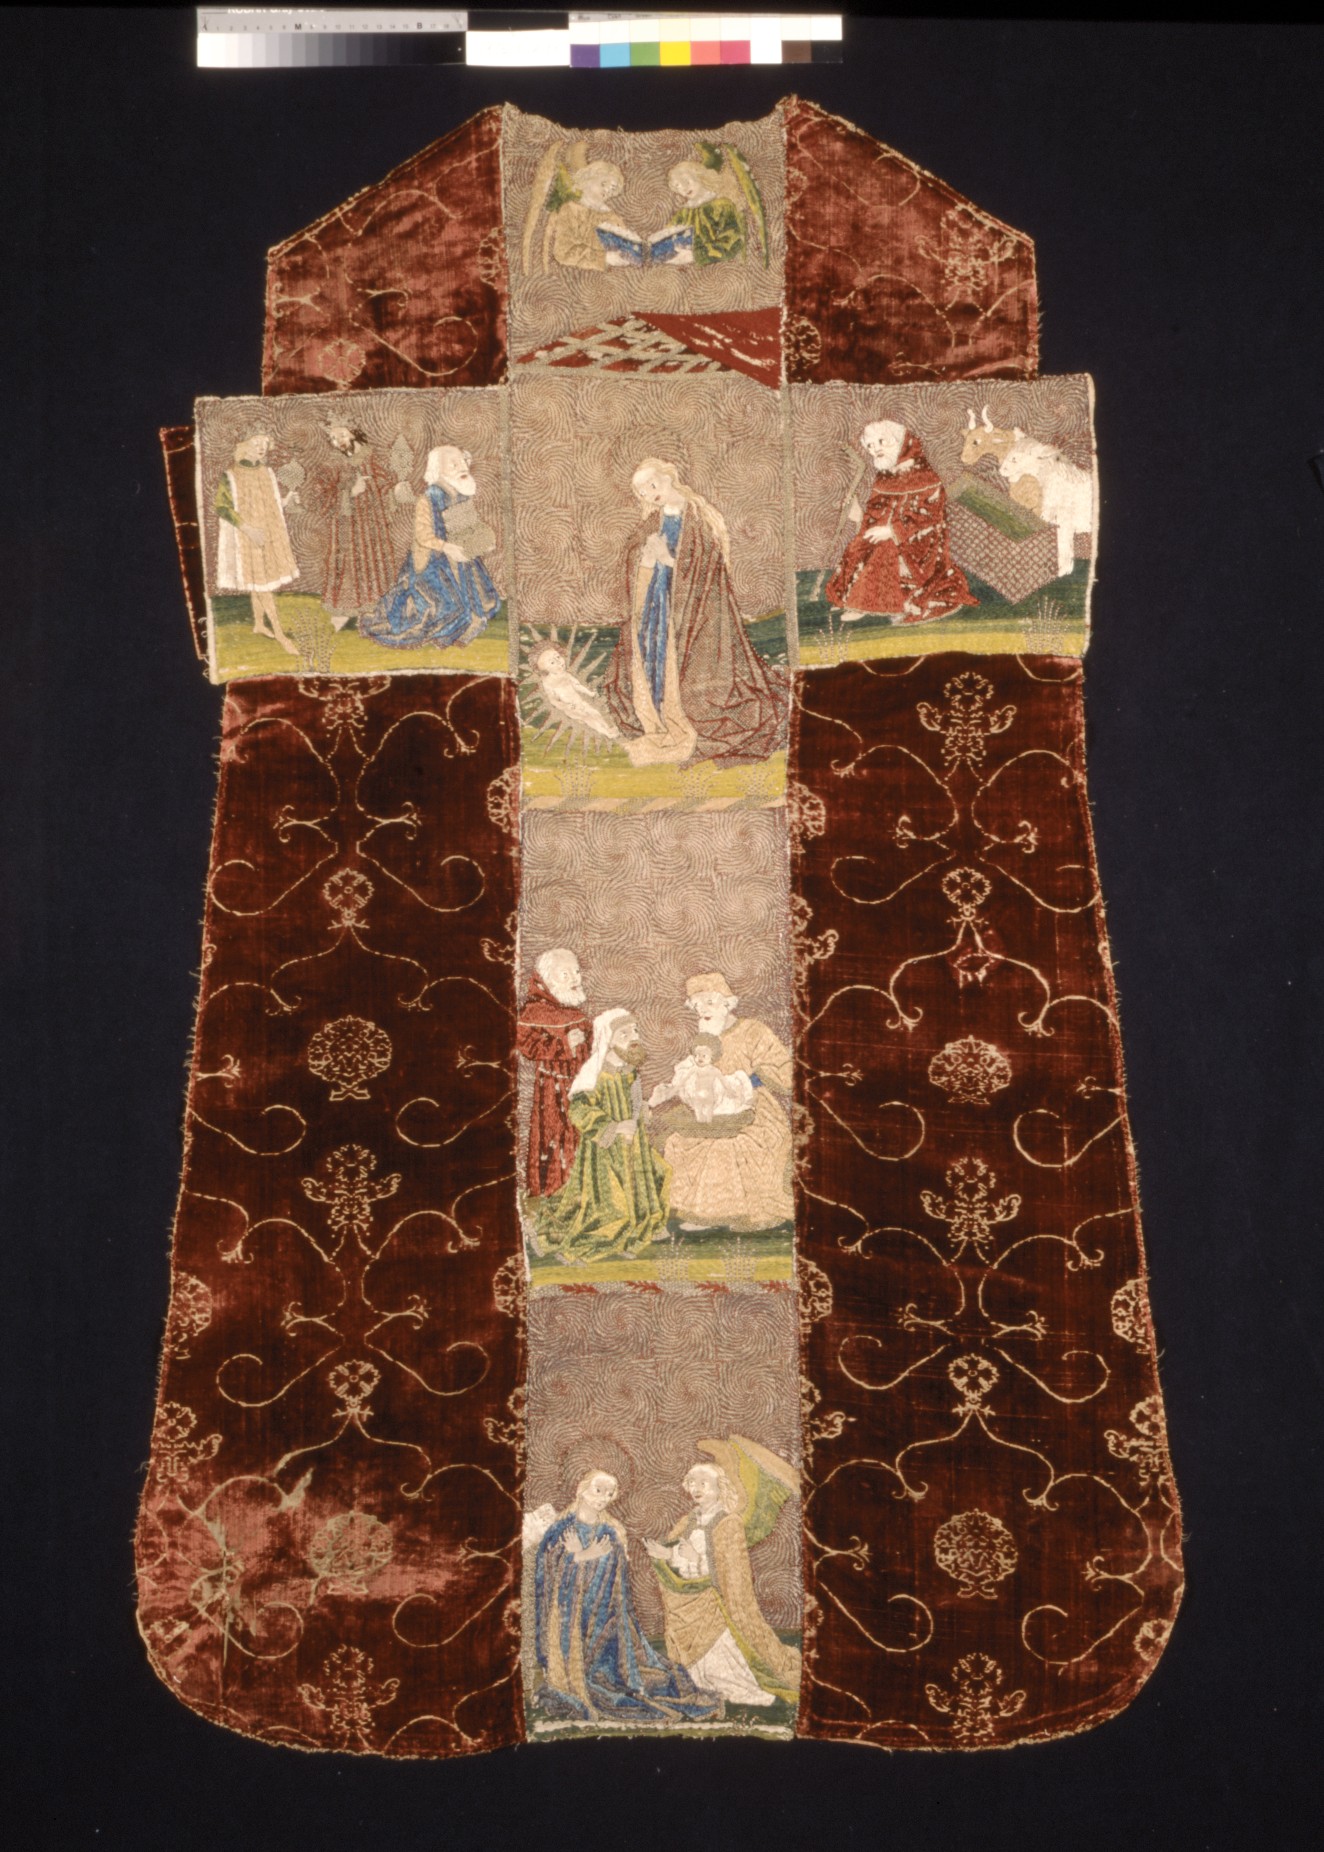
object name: chasuble with orphrey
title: Chasuble Back with an Orphrey Cross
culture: italian or spanish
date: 1451-1500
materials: animal substrate, gilt, linen, silk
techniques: embroidery, weave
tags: animals,cows,angels,virgin mary,adoration of the magi,annunciation